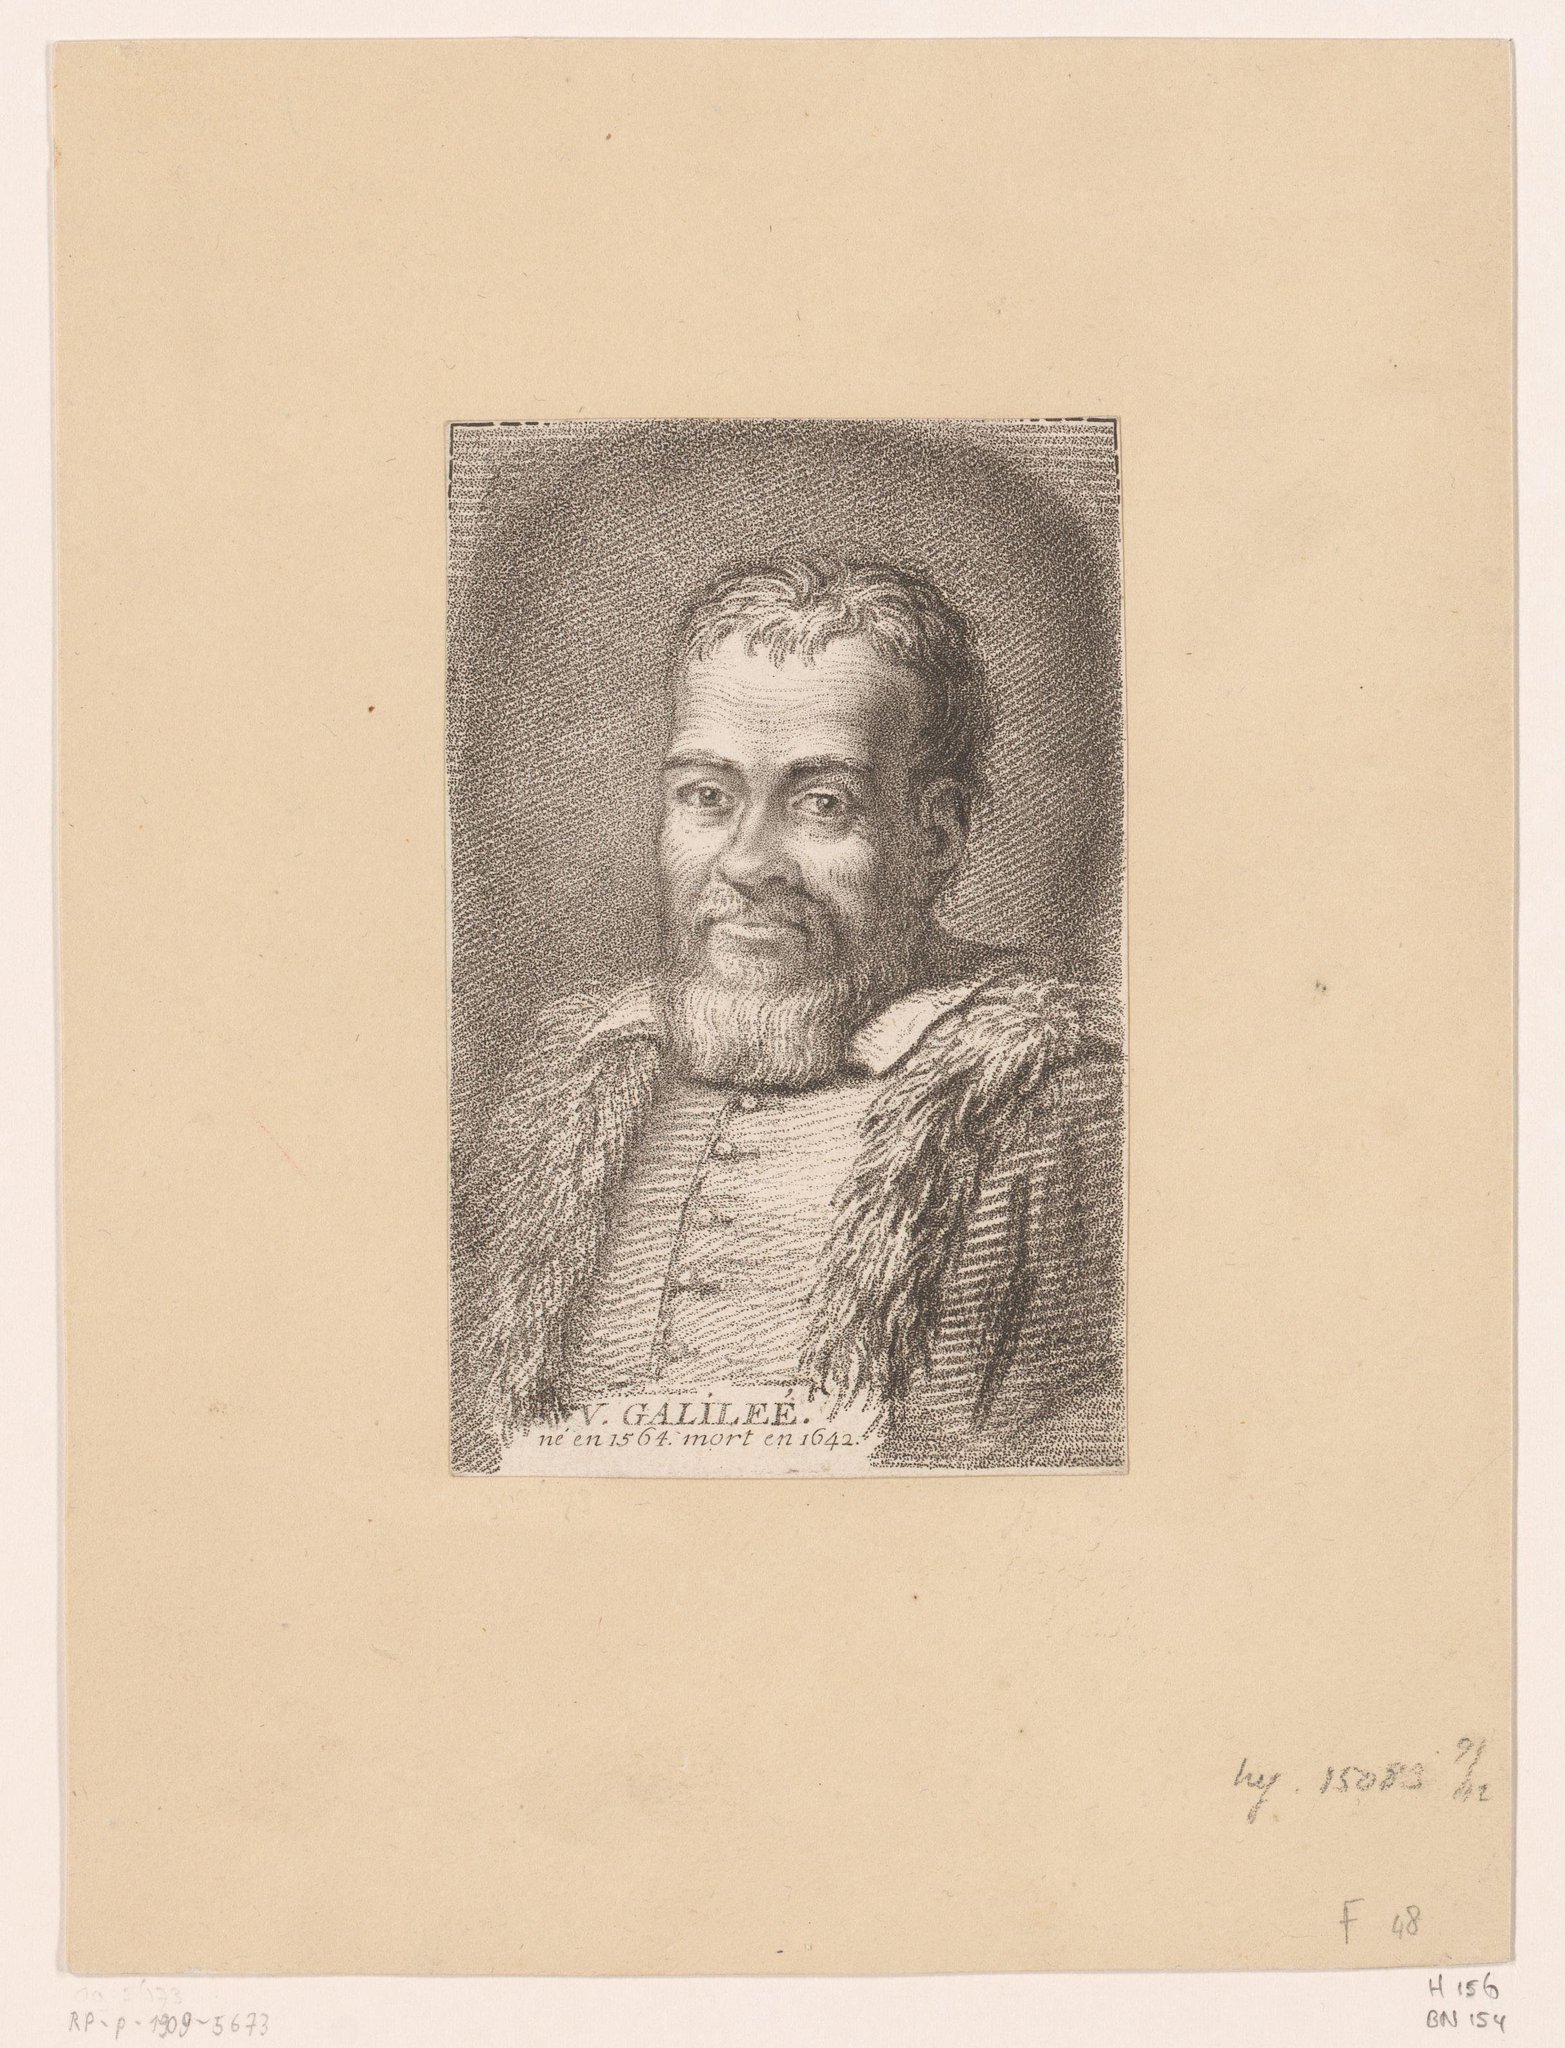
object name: print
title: Portret van Galileo Galilei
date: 1760-1769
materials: paper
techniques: printmaking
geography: france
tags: draughtsman, physicist, historical persons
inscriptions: collector's mark: Lugt 2228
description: Prent uit: Saverien, Alexandre. L'Histoire des Philosophes modernes, avec leur portrait gravé dans le goût du crayon, d'apres les desseins des plus grands peintres. Parijs: Jean Charles François, 1760-1761, dl. 5.